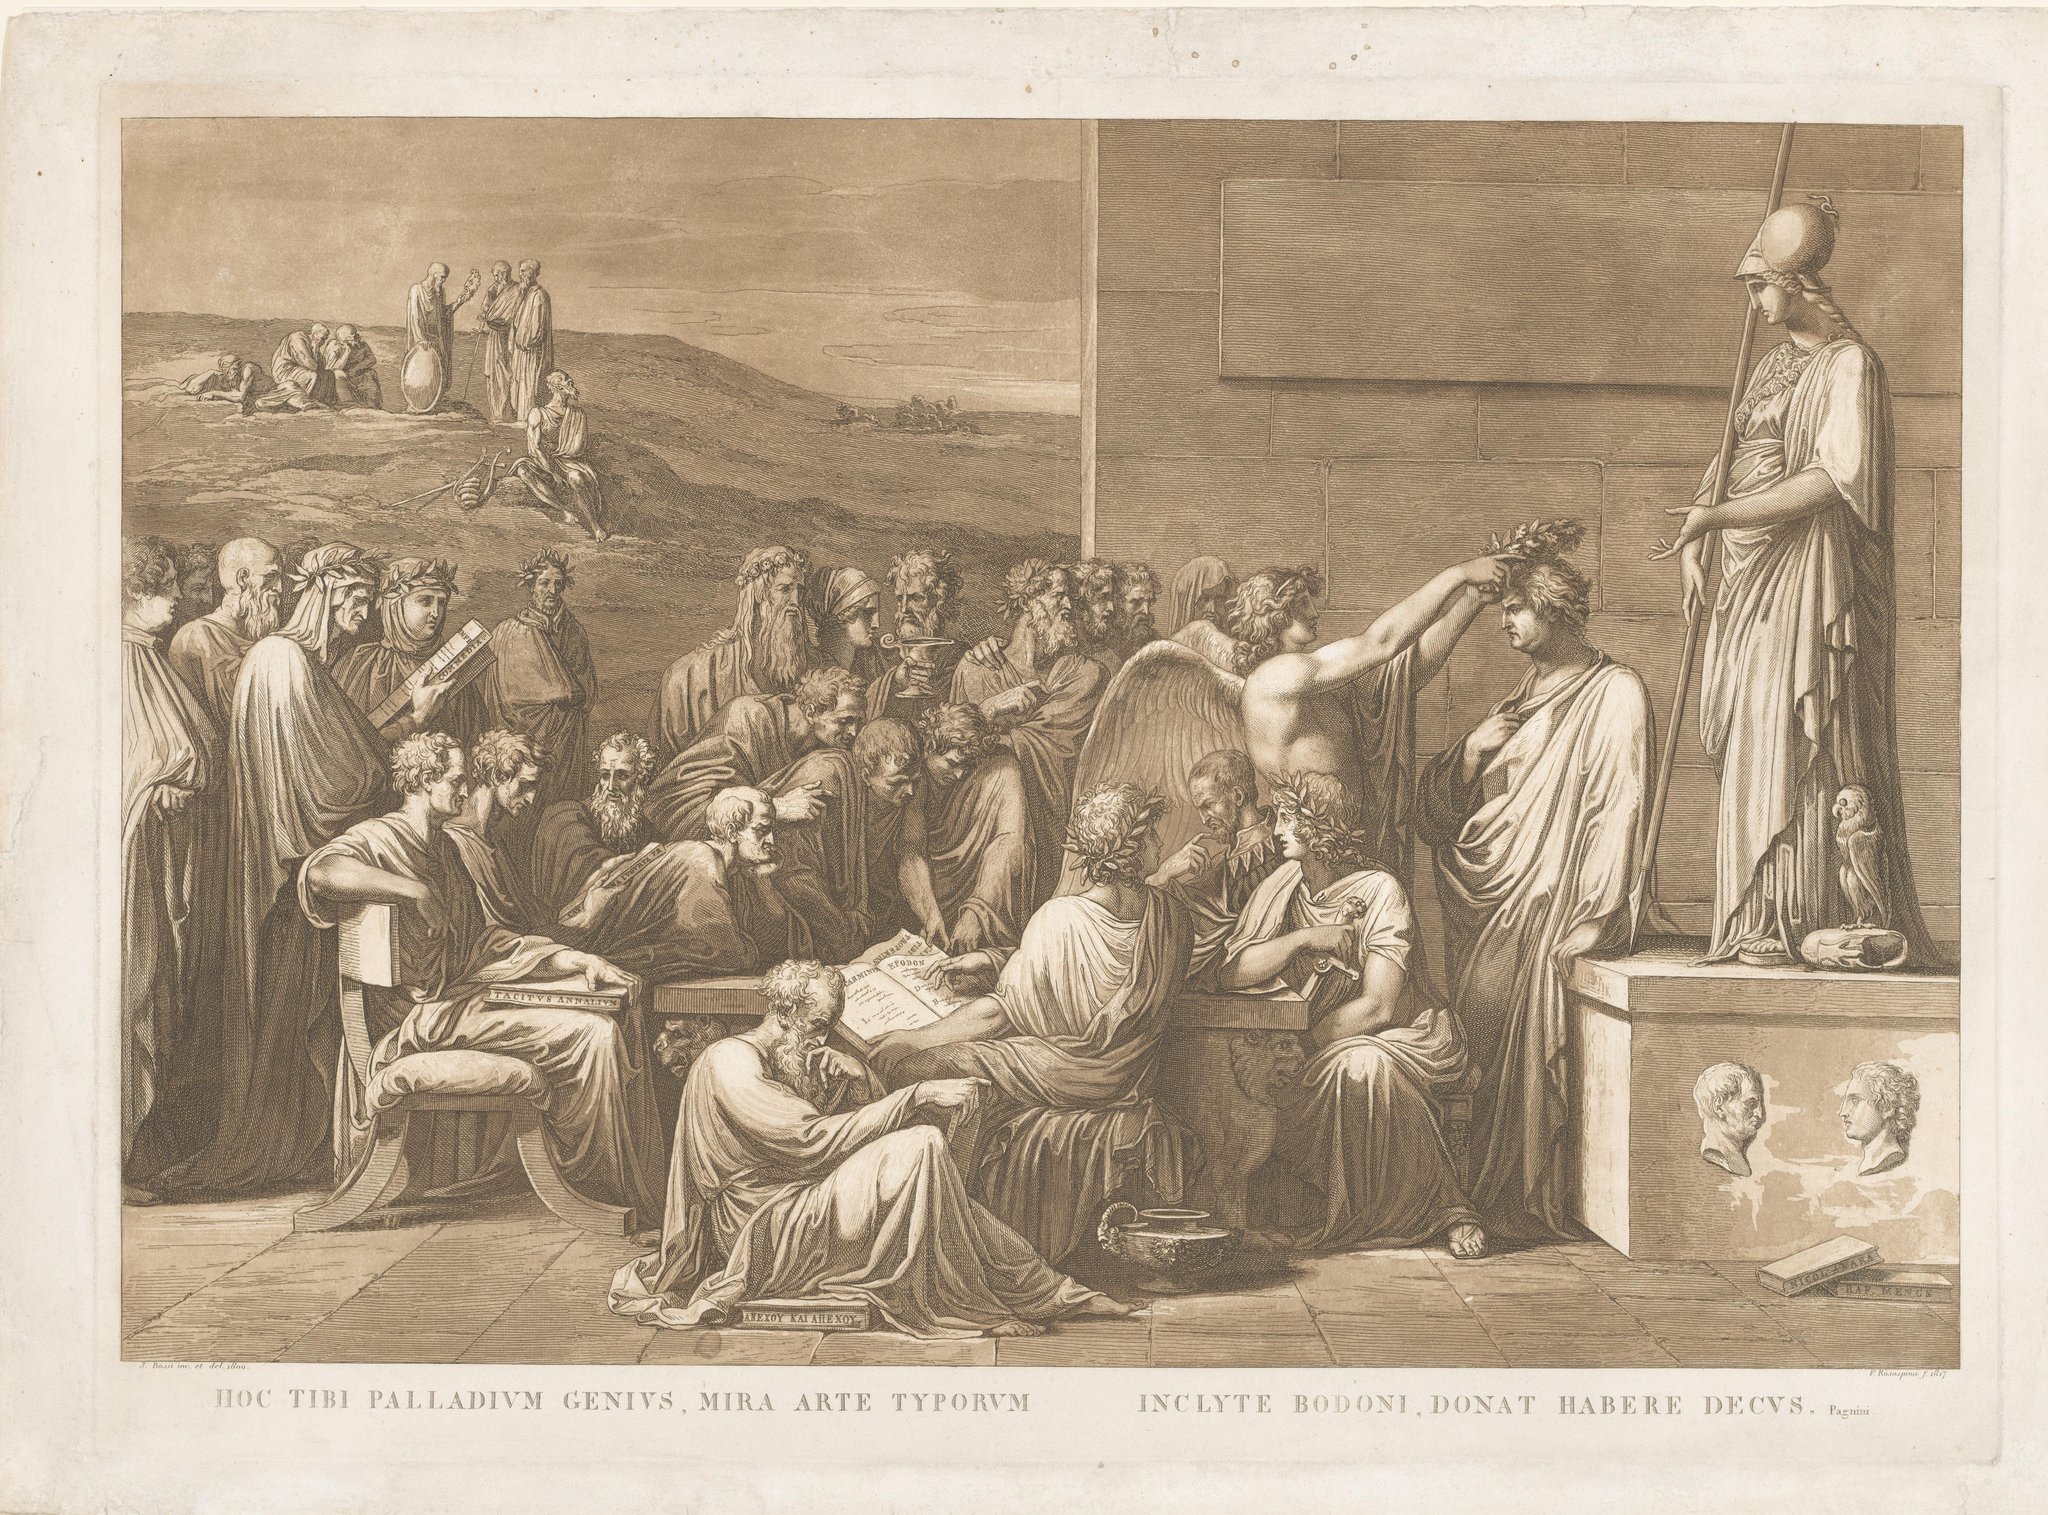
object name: print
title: Hoc tibi palladium genius, mira arte typorum / inclyte Bodoni, donat habere decus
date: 1817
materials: paper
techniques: aquatint, etching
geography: italy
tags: dante alighieri, print maker, printer, publisher, historical persons, writer, poet, author, crowning with laurel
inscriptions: collector's mark: Lugt 2760, collector's mark: Lugt 2228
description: Een groep bekende schrijvers uit de geschiedenis, onder wie Dante Alighieri en Tacitus, rond een tafel. Rechts wordt de uitgever Giovanni Battista Bodoni gelauwerd voor een sculptuur van de godin Minerva. Titel in het Latijn in ondermarge.